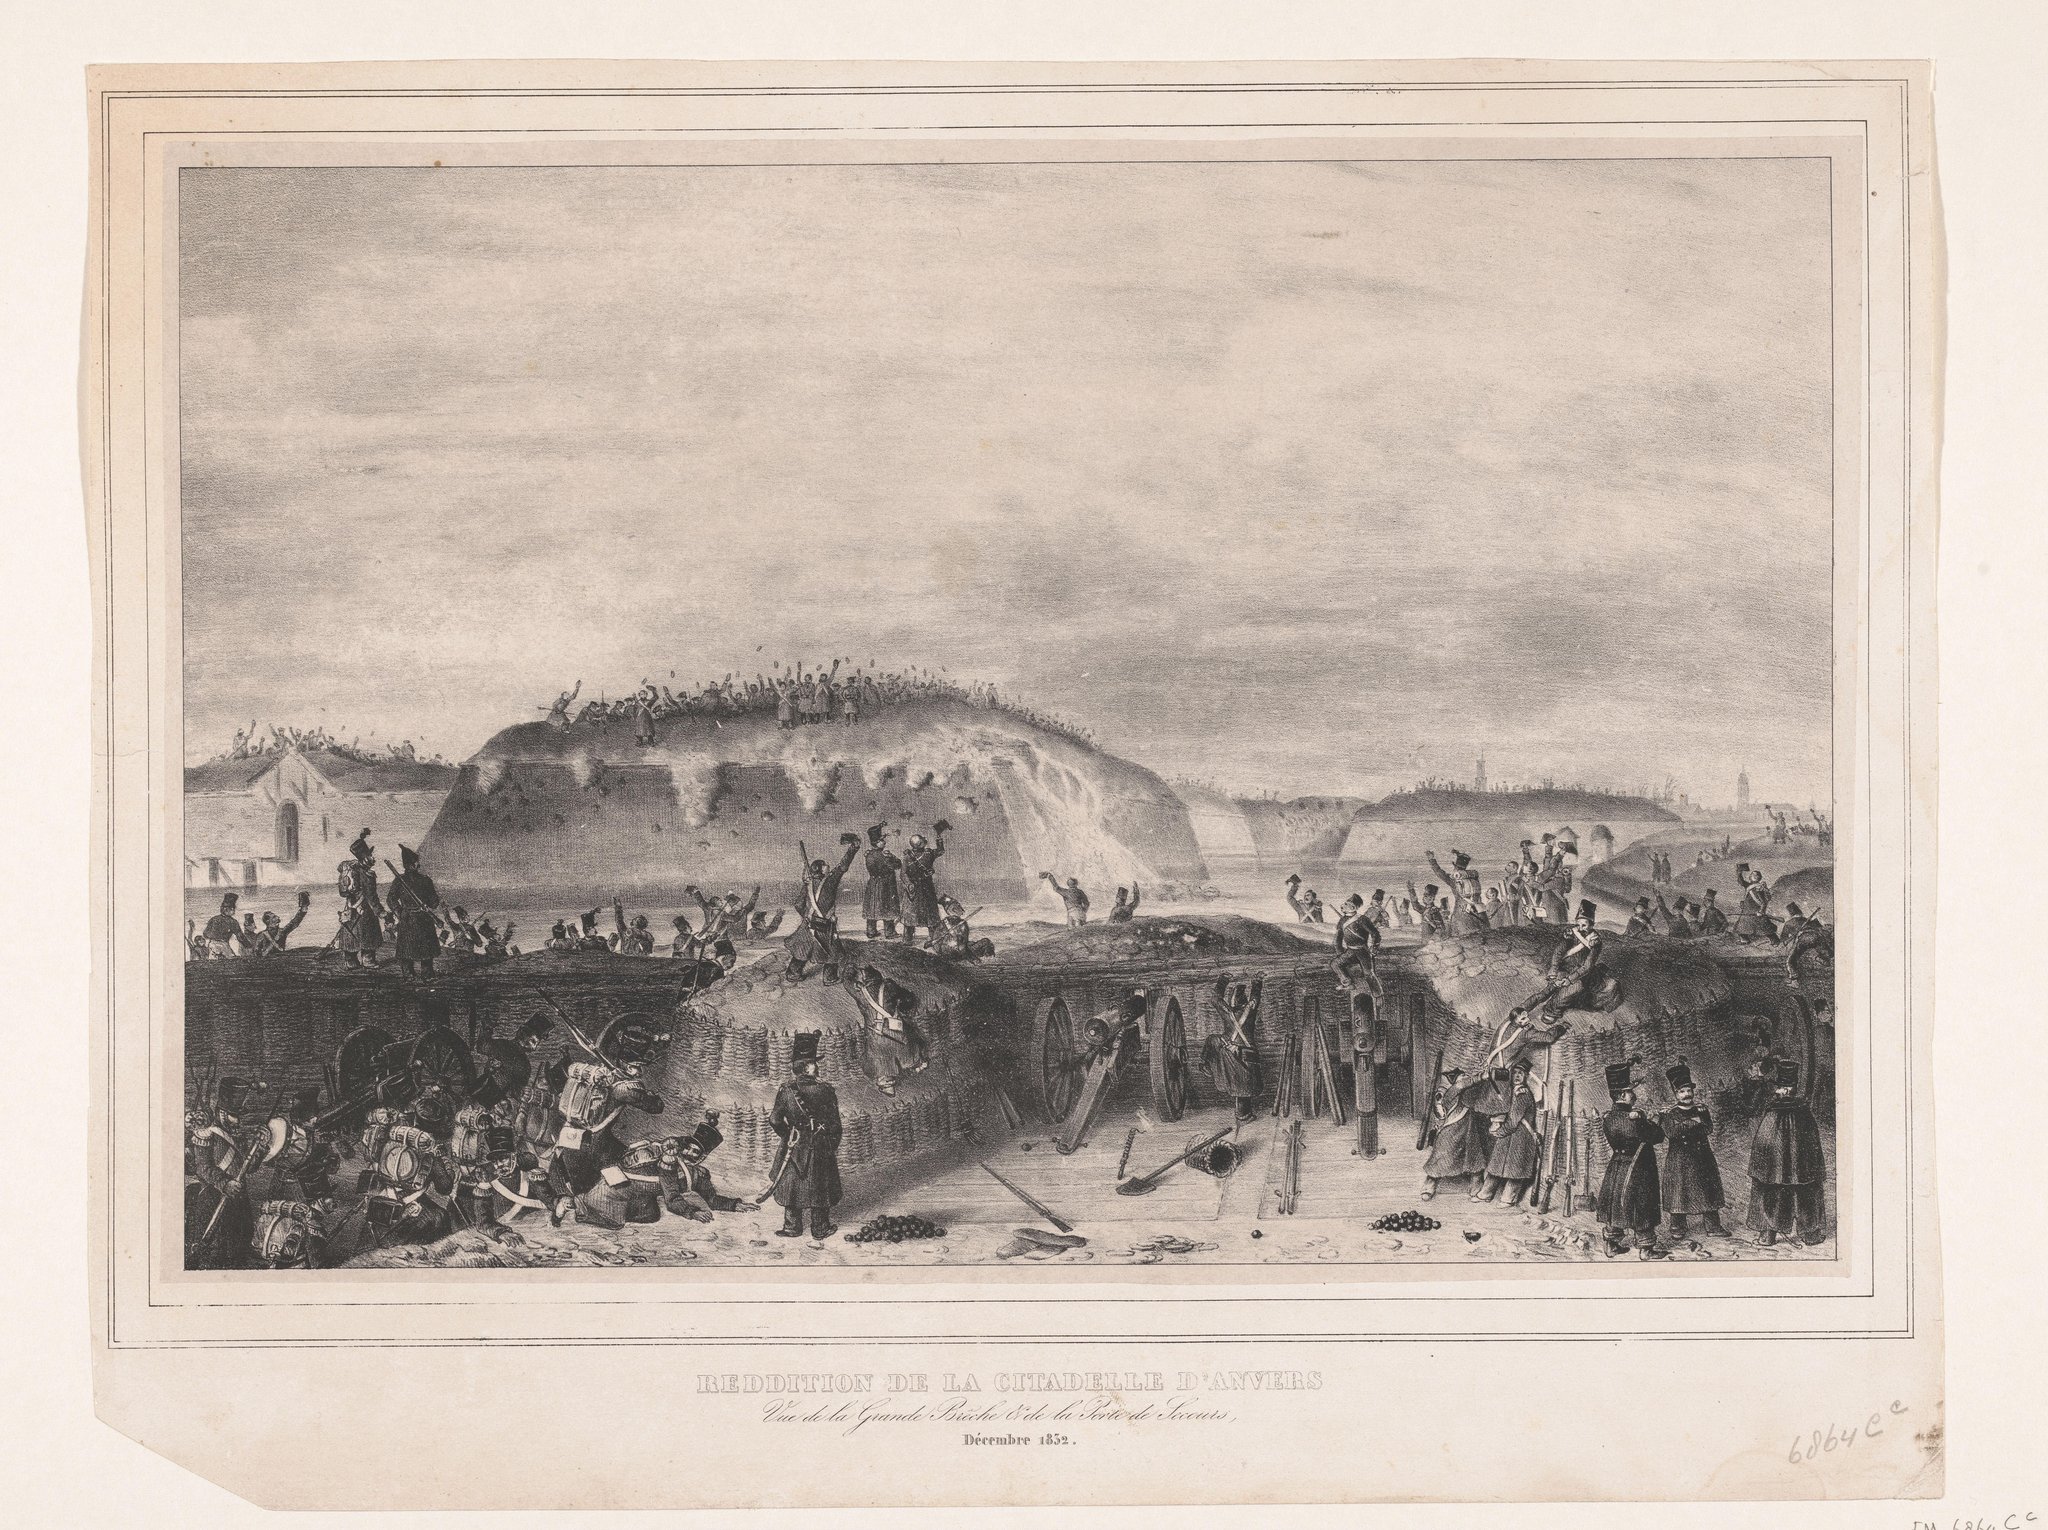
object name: print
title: Overgave van de Citadel, 1832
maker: borgé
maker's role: lithograaf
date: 1833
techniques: printmaking, lithograph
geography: belgium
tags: fortress, capture of city (after the siege)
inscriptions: collector's mark: Lugt 2228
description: Overgave van de Citadel, 23 december 1832. Soldaten staan juichend op de muren van de vesting. Derde plaat in een serie van vier grote platen van het beleg van de Citadel van Antwerpen, december 1832.